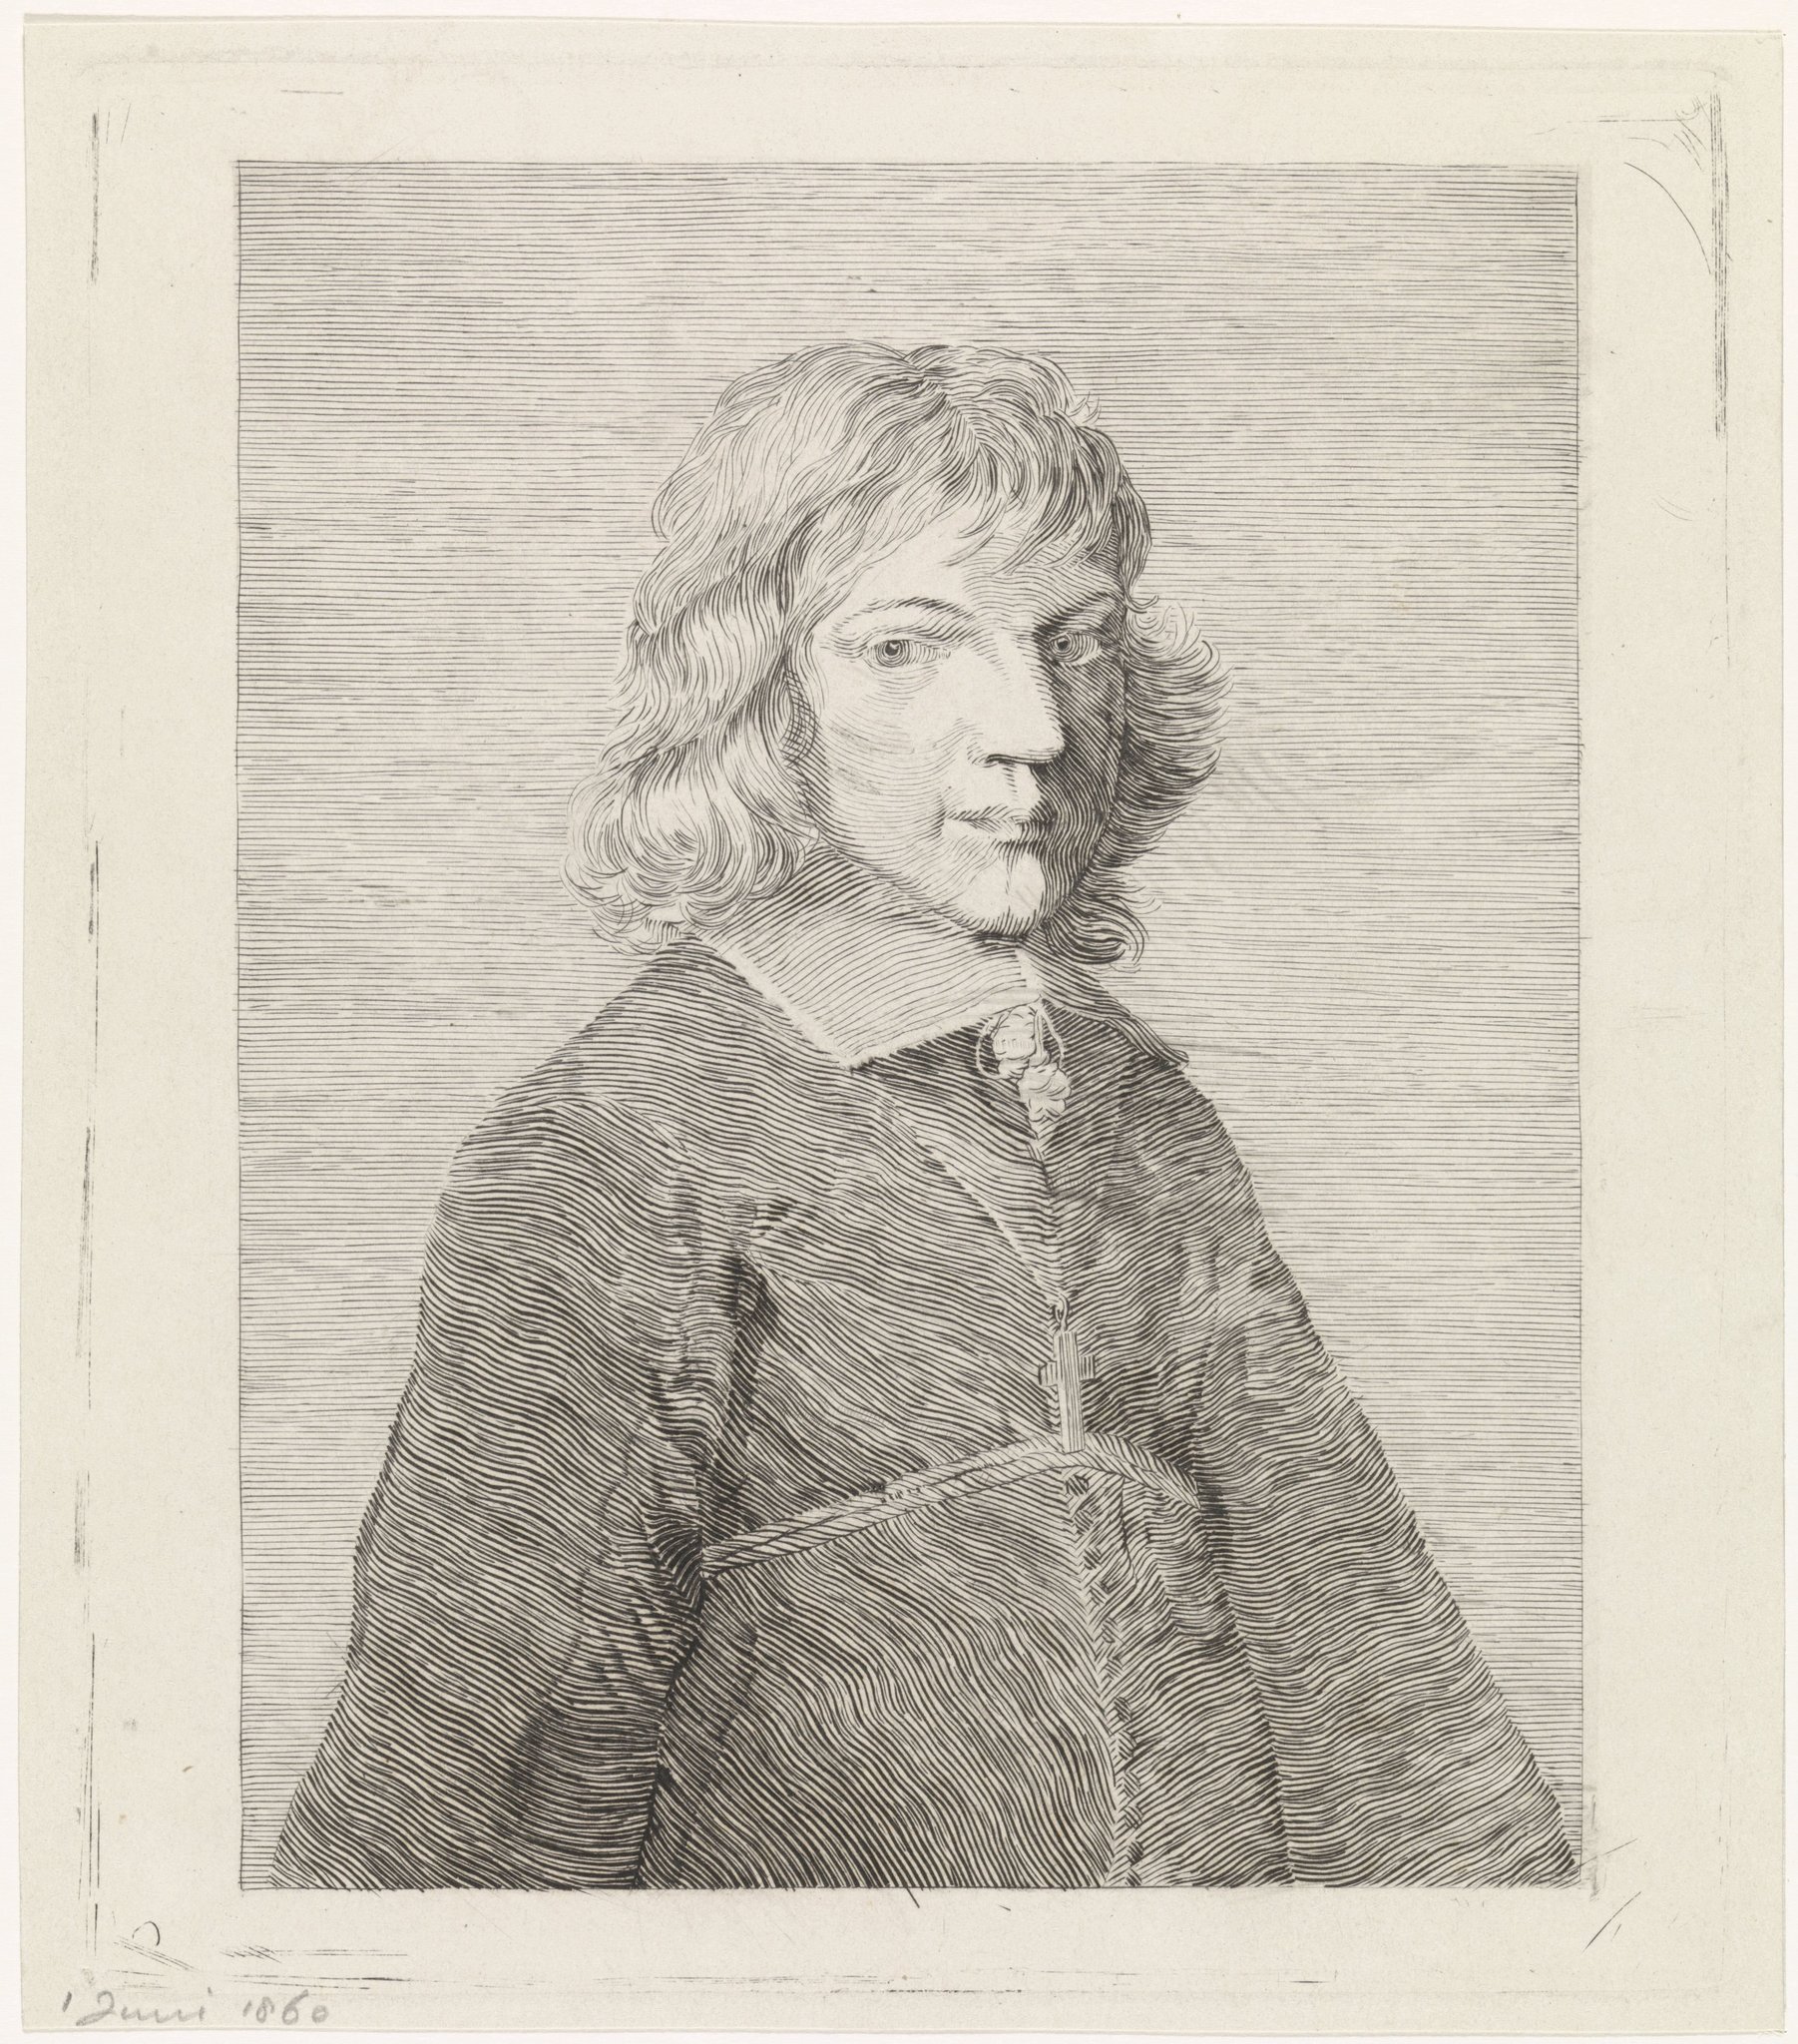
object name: print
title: Portret van een onbekende jongeman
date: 1860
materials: paper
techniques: etching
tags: adult man, the cross ~ symbols of christ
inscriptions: collector's mark: Lugt 2228, inscription: ‘1 juni 1860’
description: Portret ten halven lijve naar rechts van een onbekende jongeman met een kruis om zijn nek.